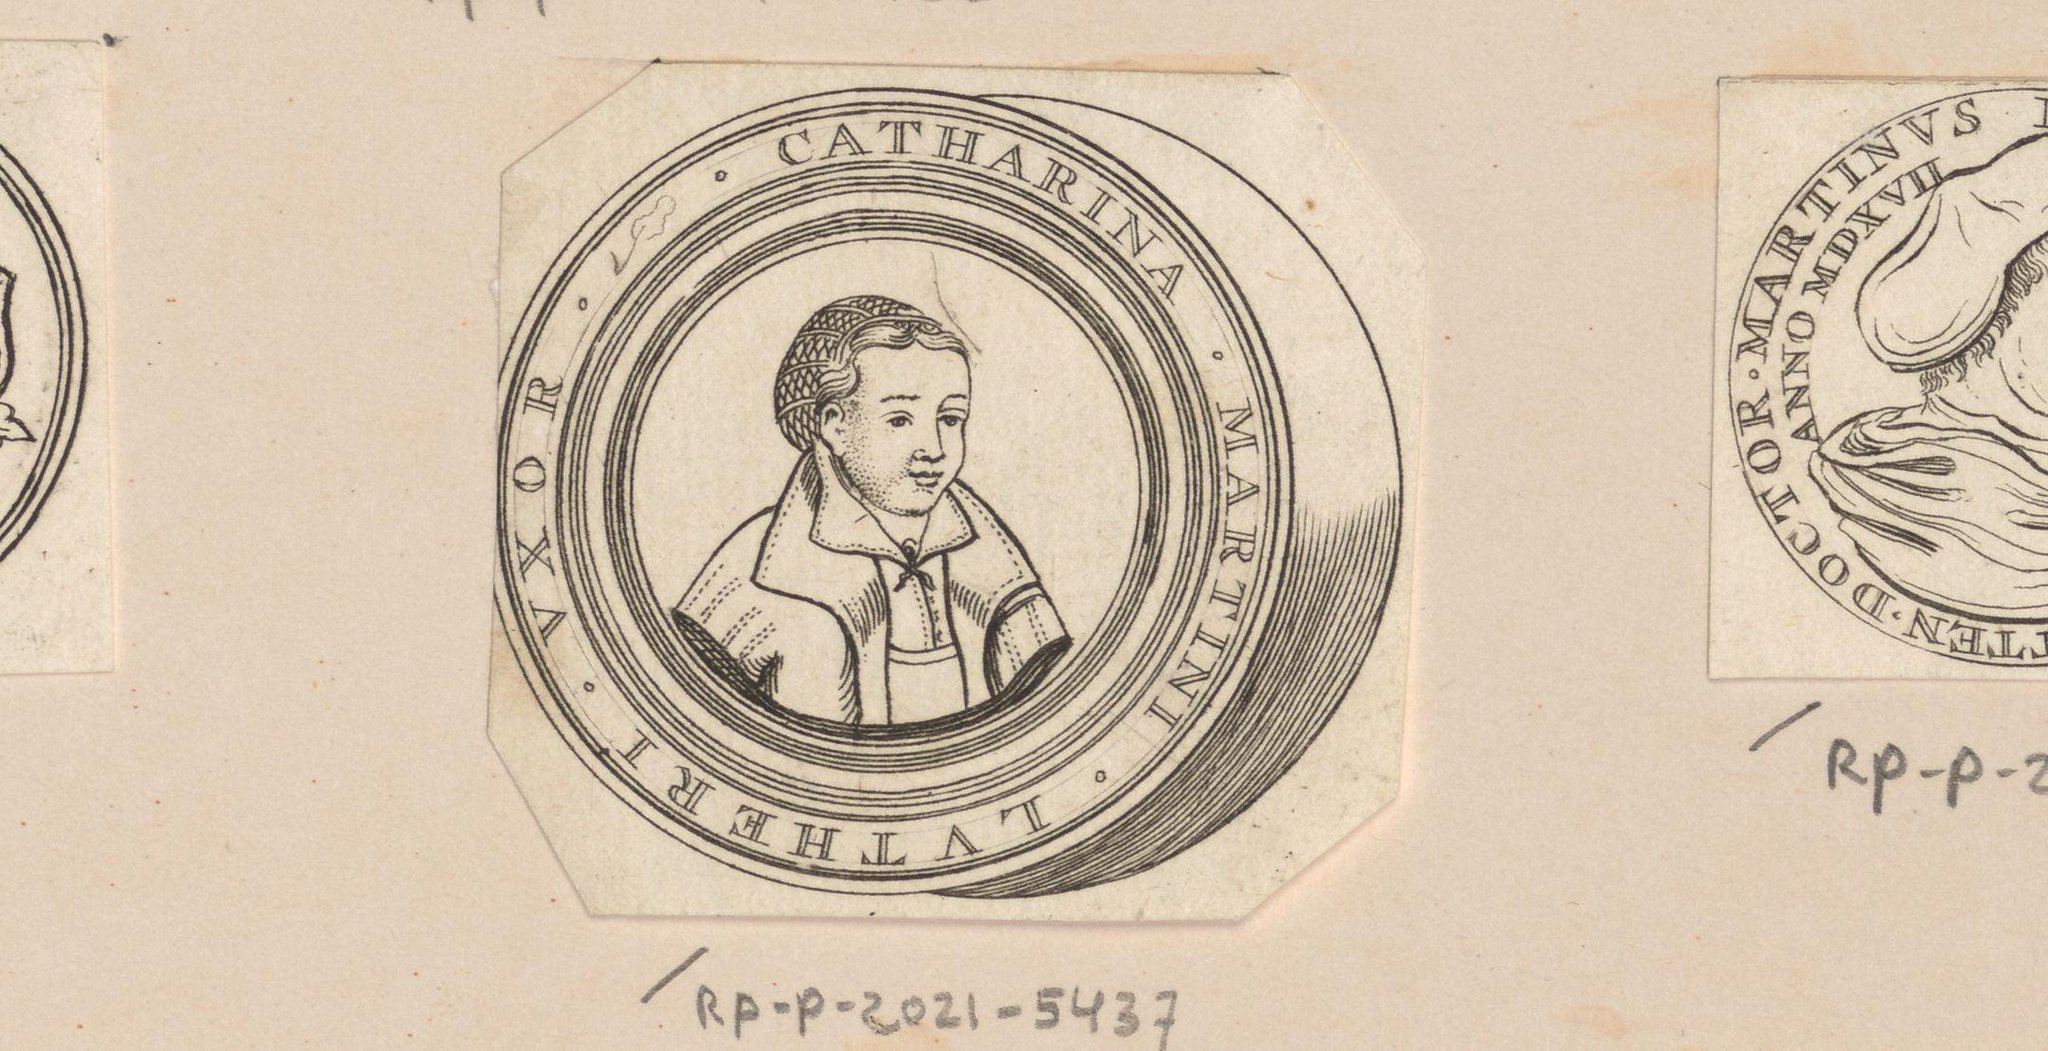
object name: print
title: Dambordschijf met het portret van Katharina von Bora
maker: Anonymous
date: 1728-1734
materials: paper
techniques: engraving, etching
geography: northern netherlands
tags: historical persons - bb - woman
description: Prent met tekst in boekdruk op verso gebruikt in: Seckendorf, Veit-Ludwig von. Uitvoerige en onpartydige historie der reformatie door dr. Martin Luther (...). Delft: Reinier Boitet, 1728, dl. 3. En in de druk uit 1730, en mogelijk ook al in 1726. En in: Juncker, Christian. De goude en zilvere eergedagtenis van Dr. M. Luther (...). Den Haag: s.n., 1734.